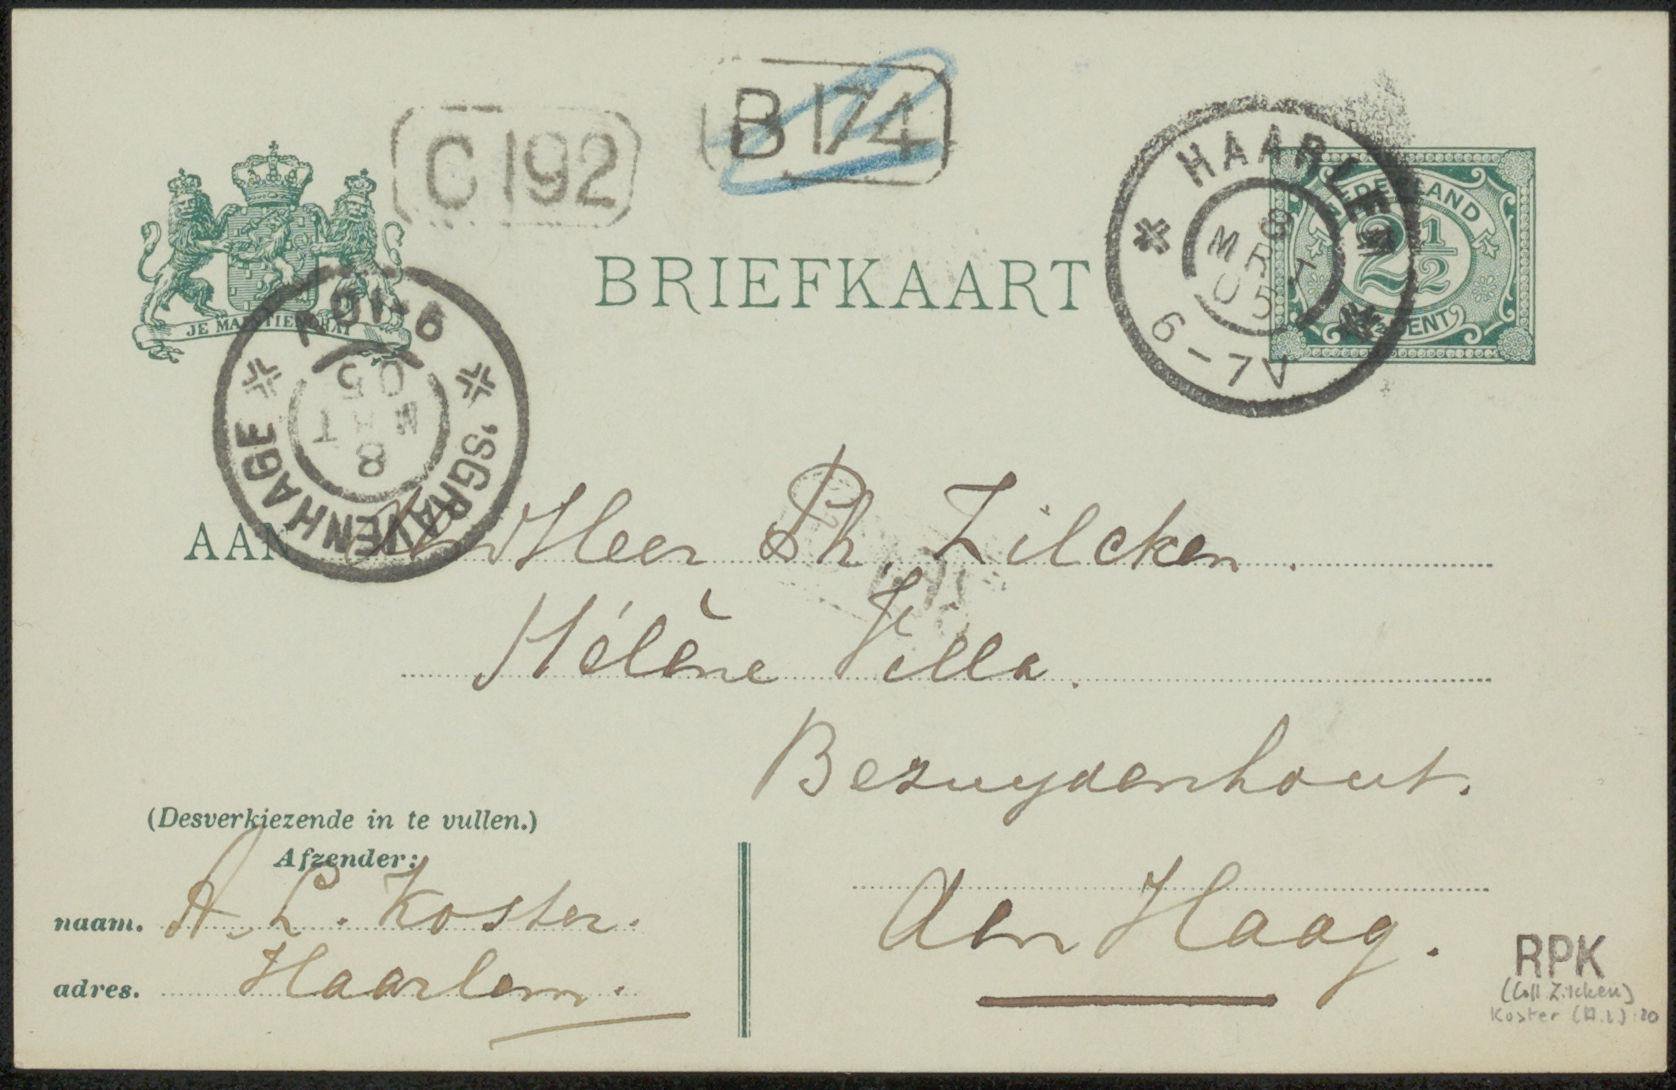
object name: postcard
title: Briefkaart aan Philip Zilcken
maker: anton l. koster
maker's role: draughtsman, painter, print maker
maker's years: 1859-1937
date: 1905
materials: cardboard, ink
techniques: pen, writing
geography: haarlem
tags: willy martens, the hague, painter, draughtsman, philip zilcken, the graphic arts, exhibition ~ art, new york (city), venice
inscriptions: collector's mark: ‘RPK’